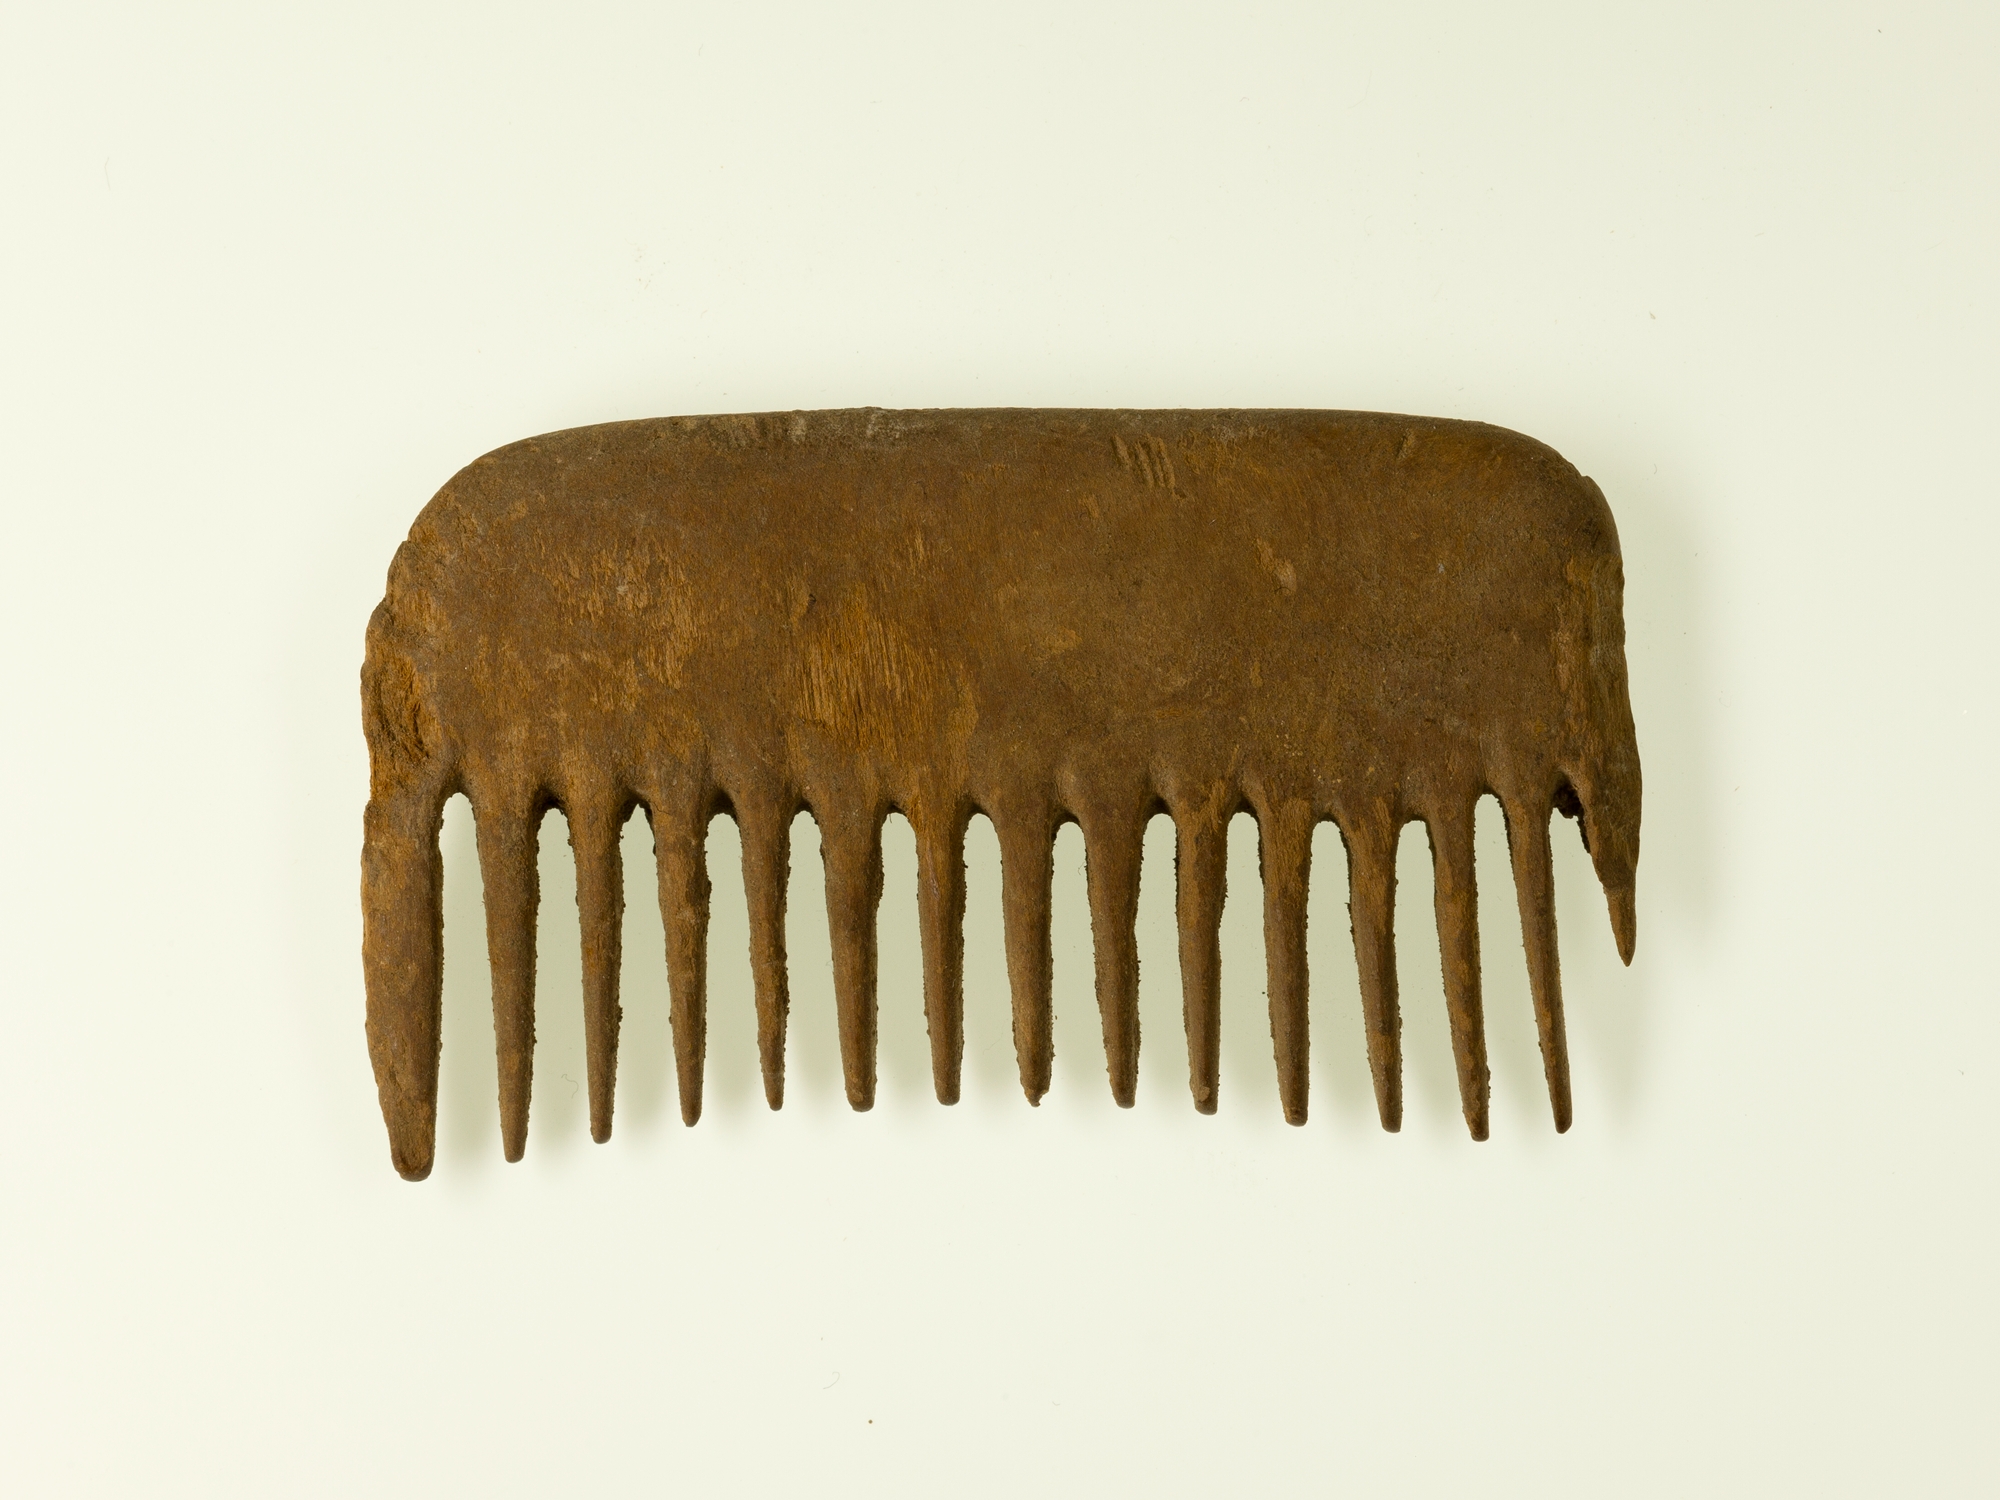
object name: comb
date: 1295-1070 BCE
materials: wood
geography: egypt